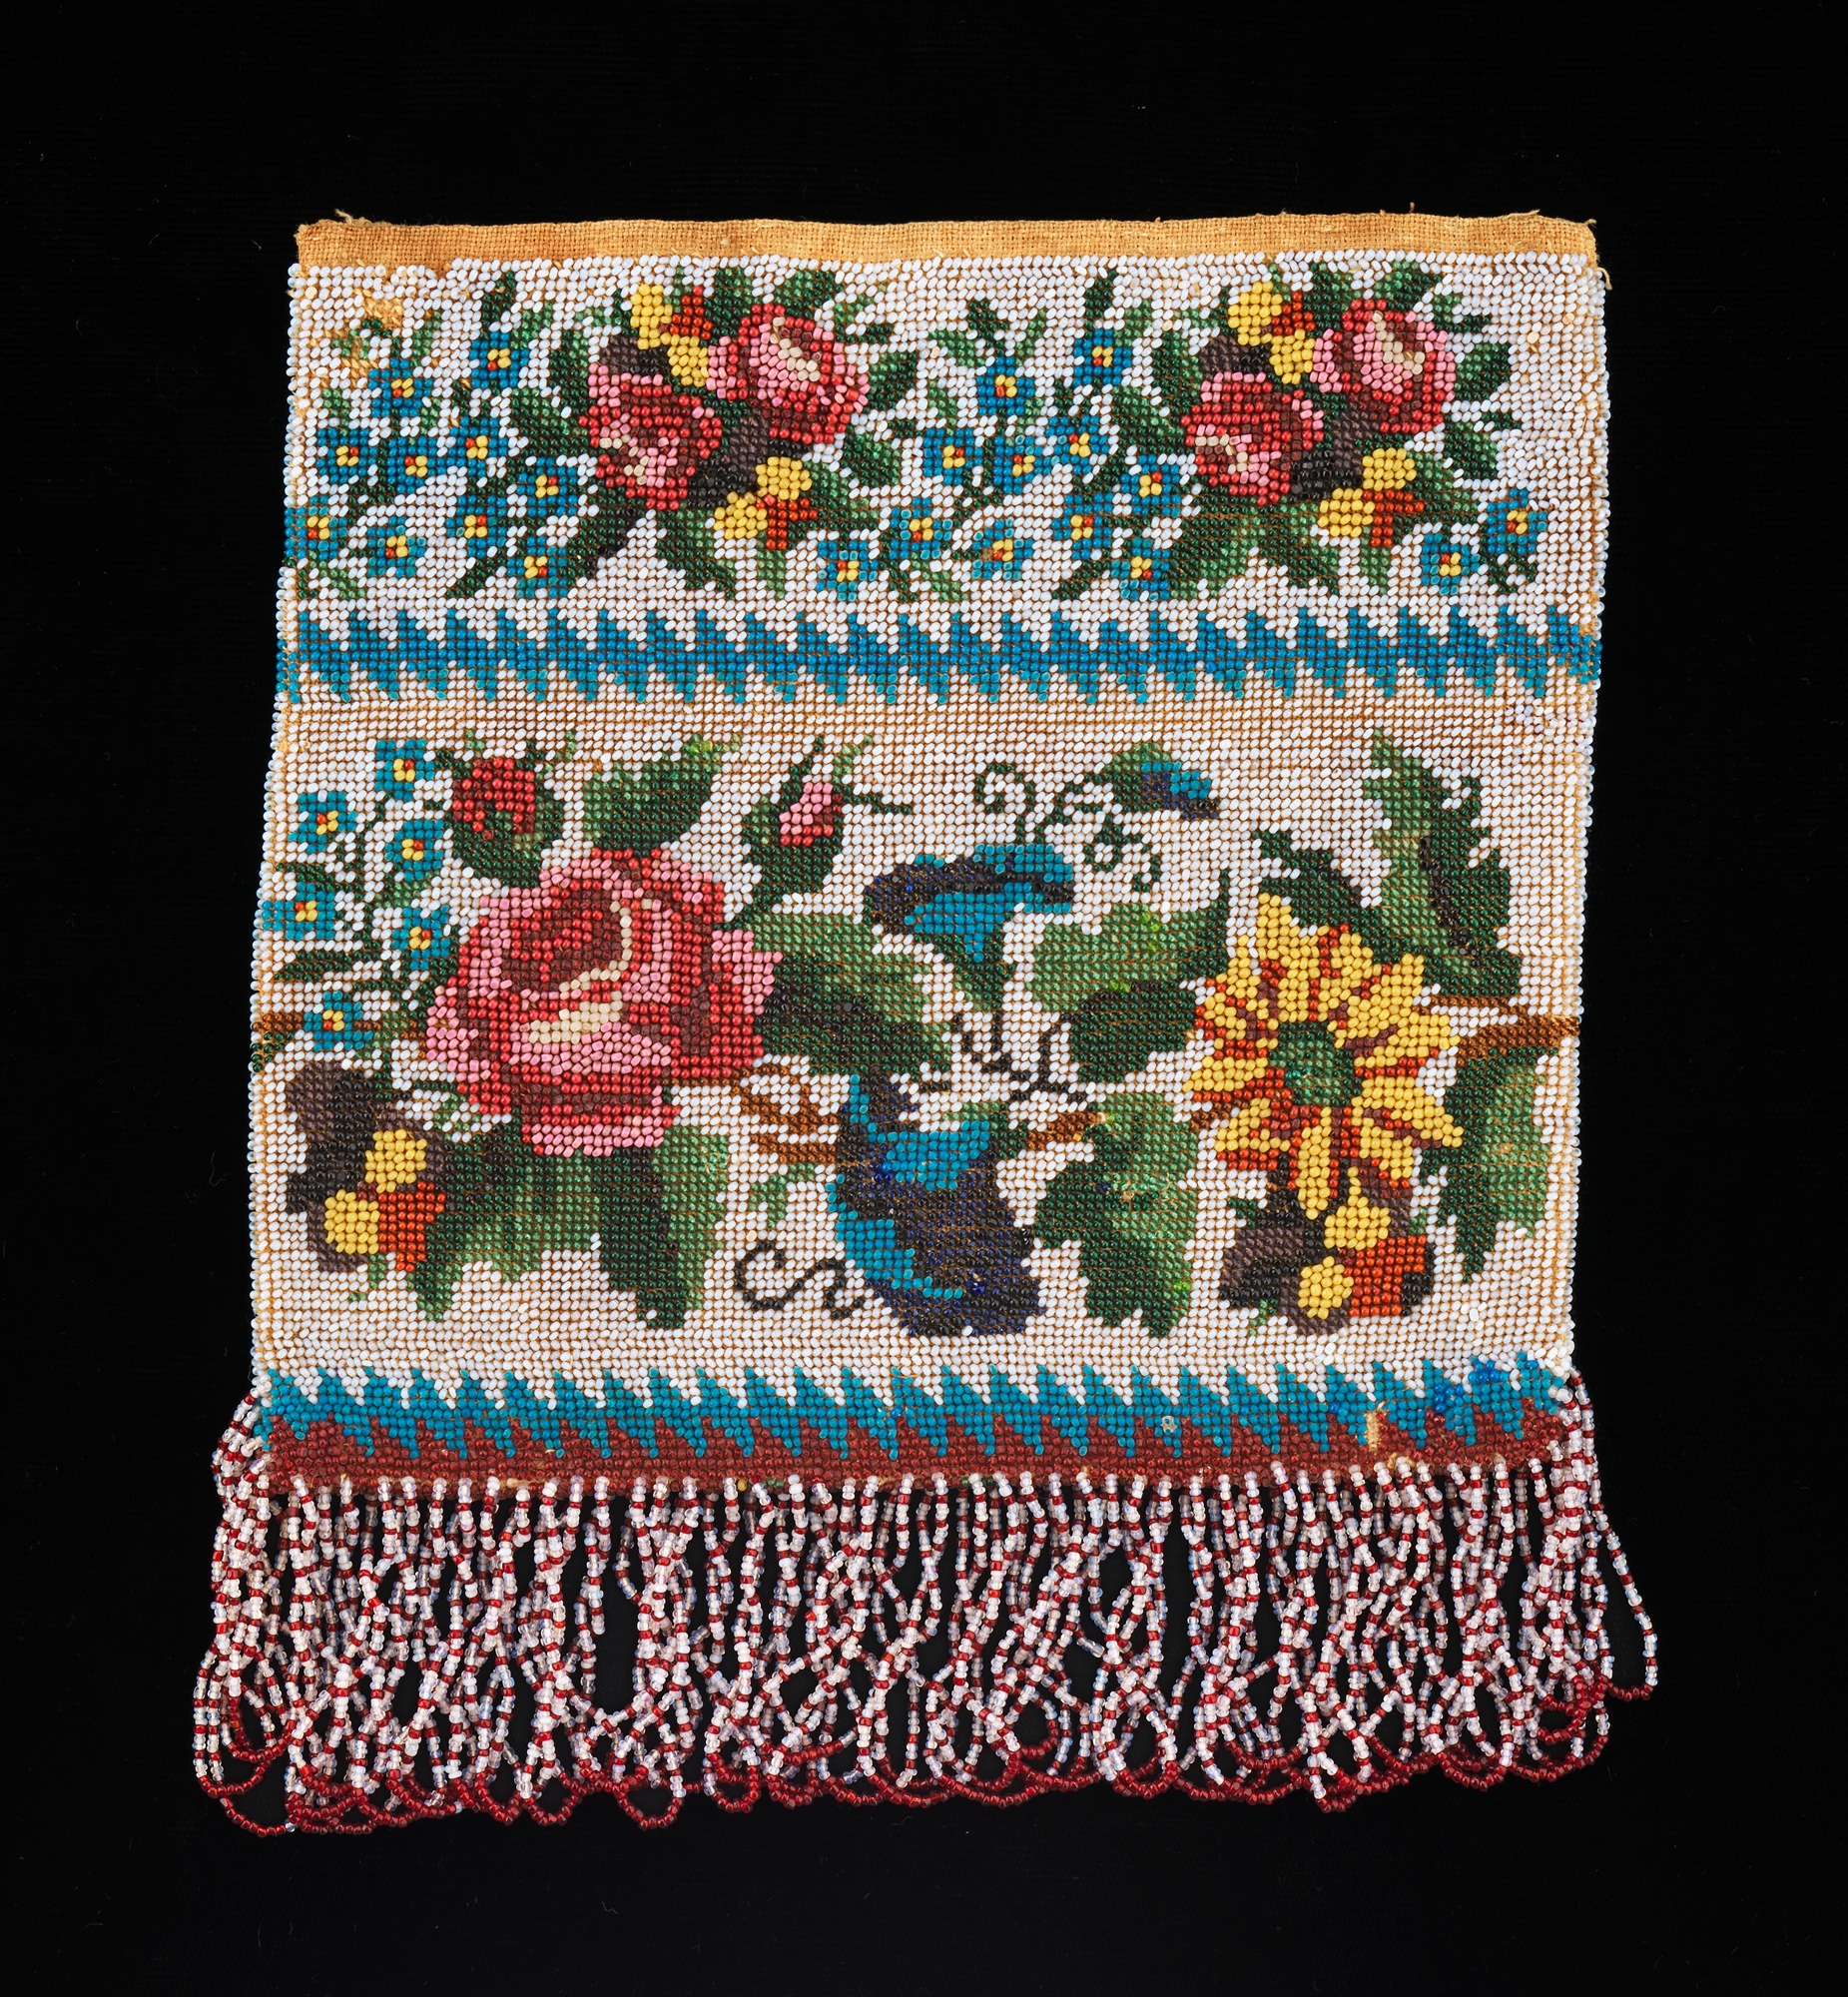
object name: pouch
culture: american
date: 1820-1840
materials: glass, linen